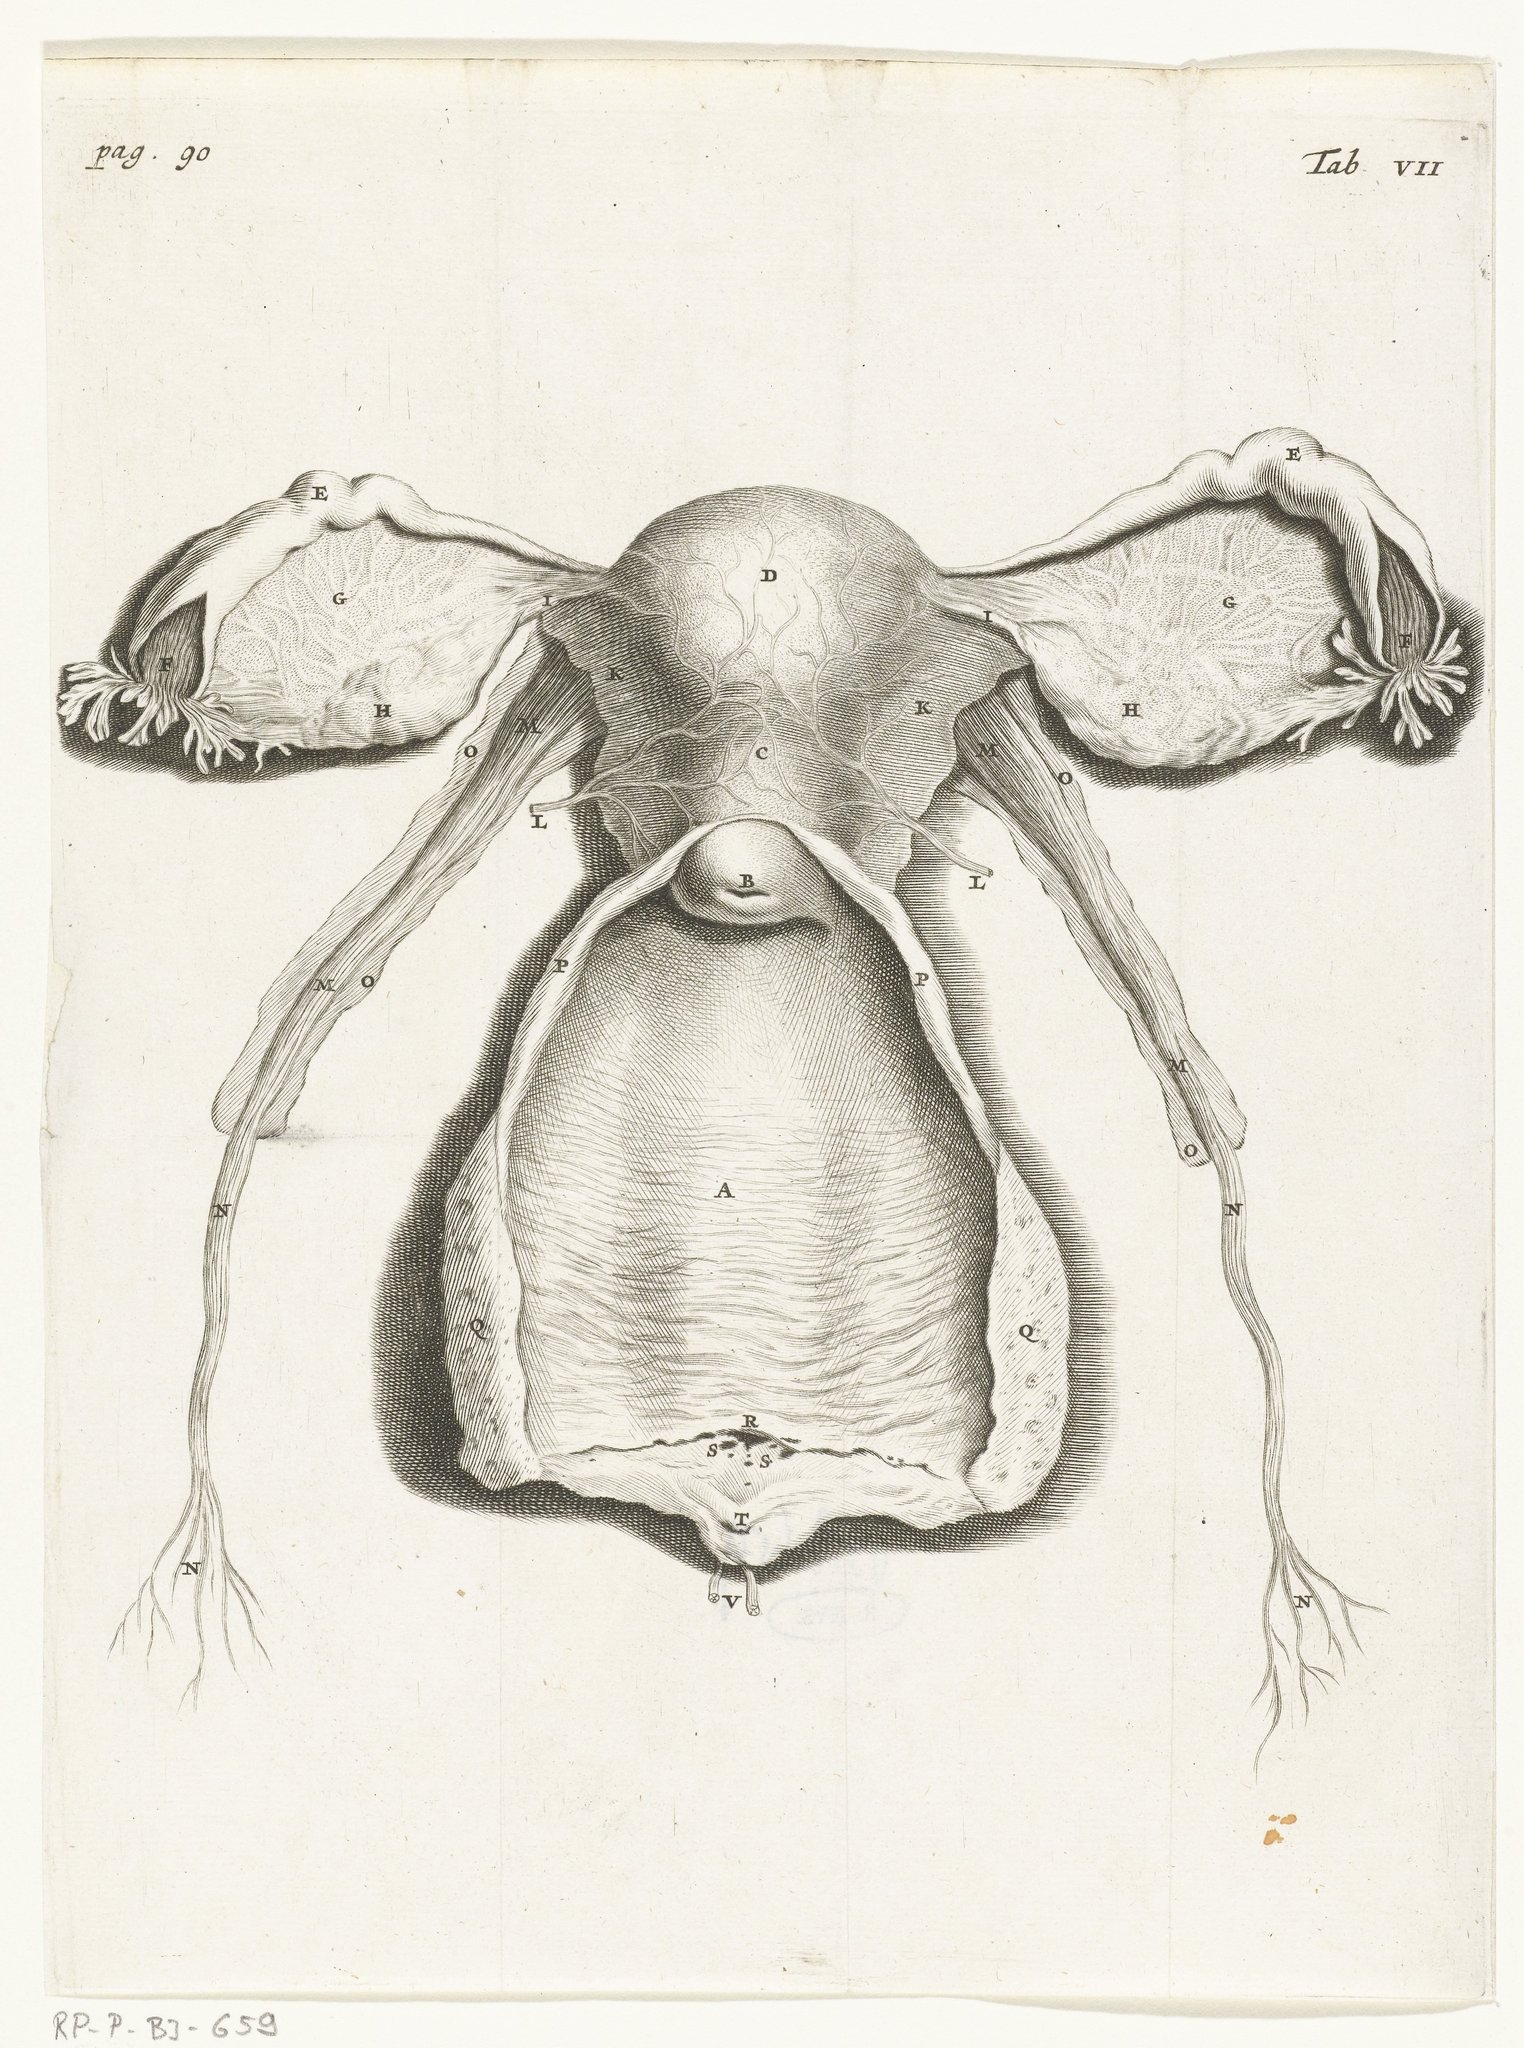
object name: book illustration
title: Boekillustratie voor: Reinier de Graaf, De mulierum organis generationi inservientibus tractatus novus, 1672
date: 1672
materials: paper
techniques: engraving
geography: leiden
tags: female sexual organs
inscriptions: collector's mark: Lugt 2228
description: Illustratie voor: Reinier de Graaf, De mulierum organis generationi inservientibus tractatus novus, Leiden, ex officina Hackiana, 1672